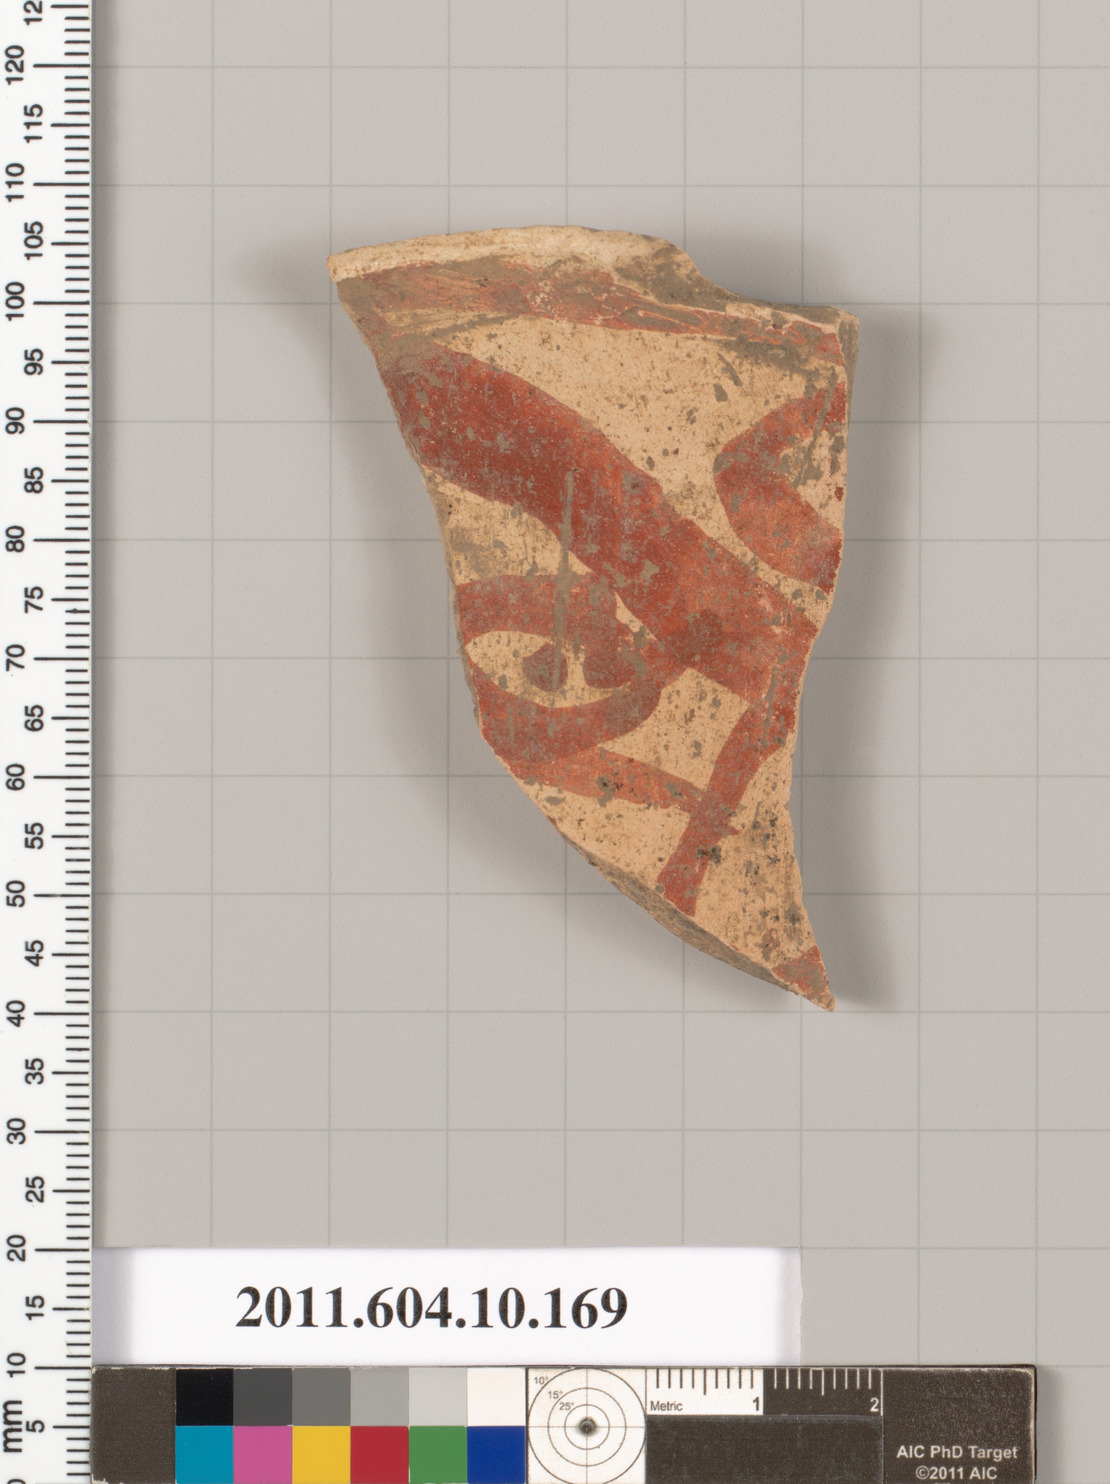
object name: amphora fragment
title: Terracotta fragment of an amphora (jar)?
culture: etruscan, subgeometric, caeretan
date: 700-675 BCE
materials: terracotta